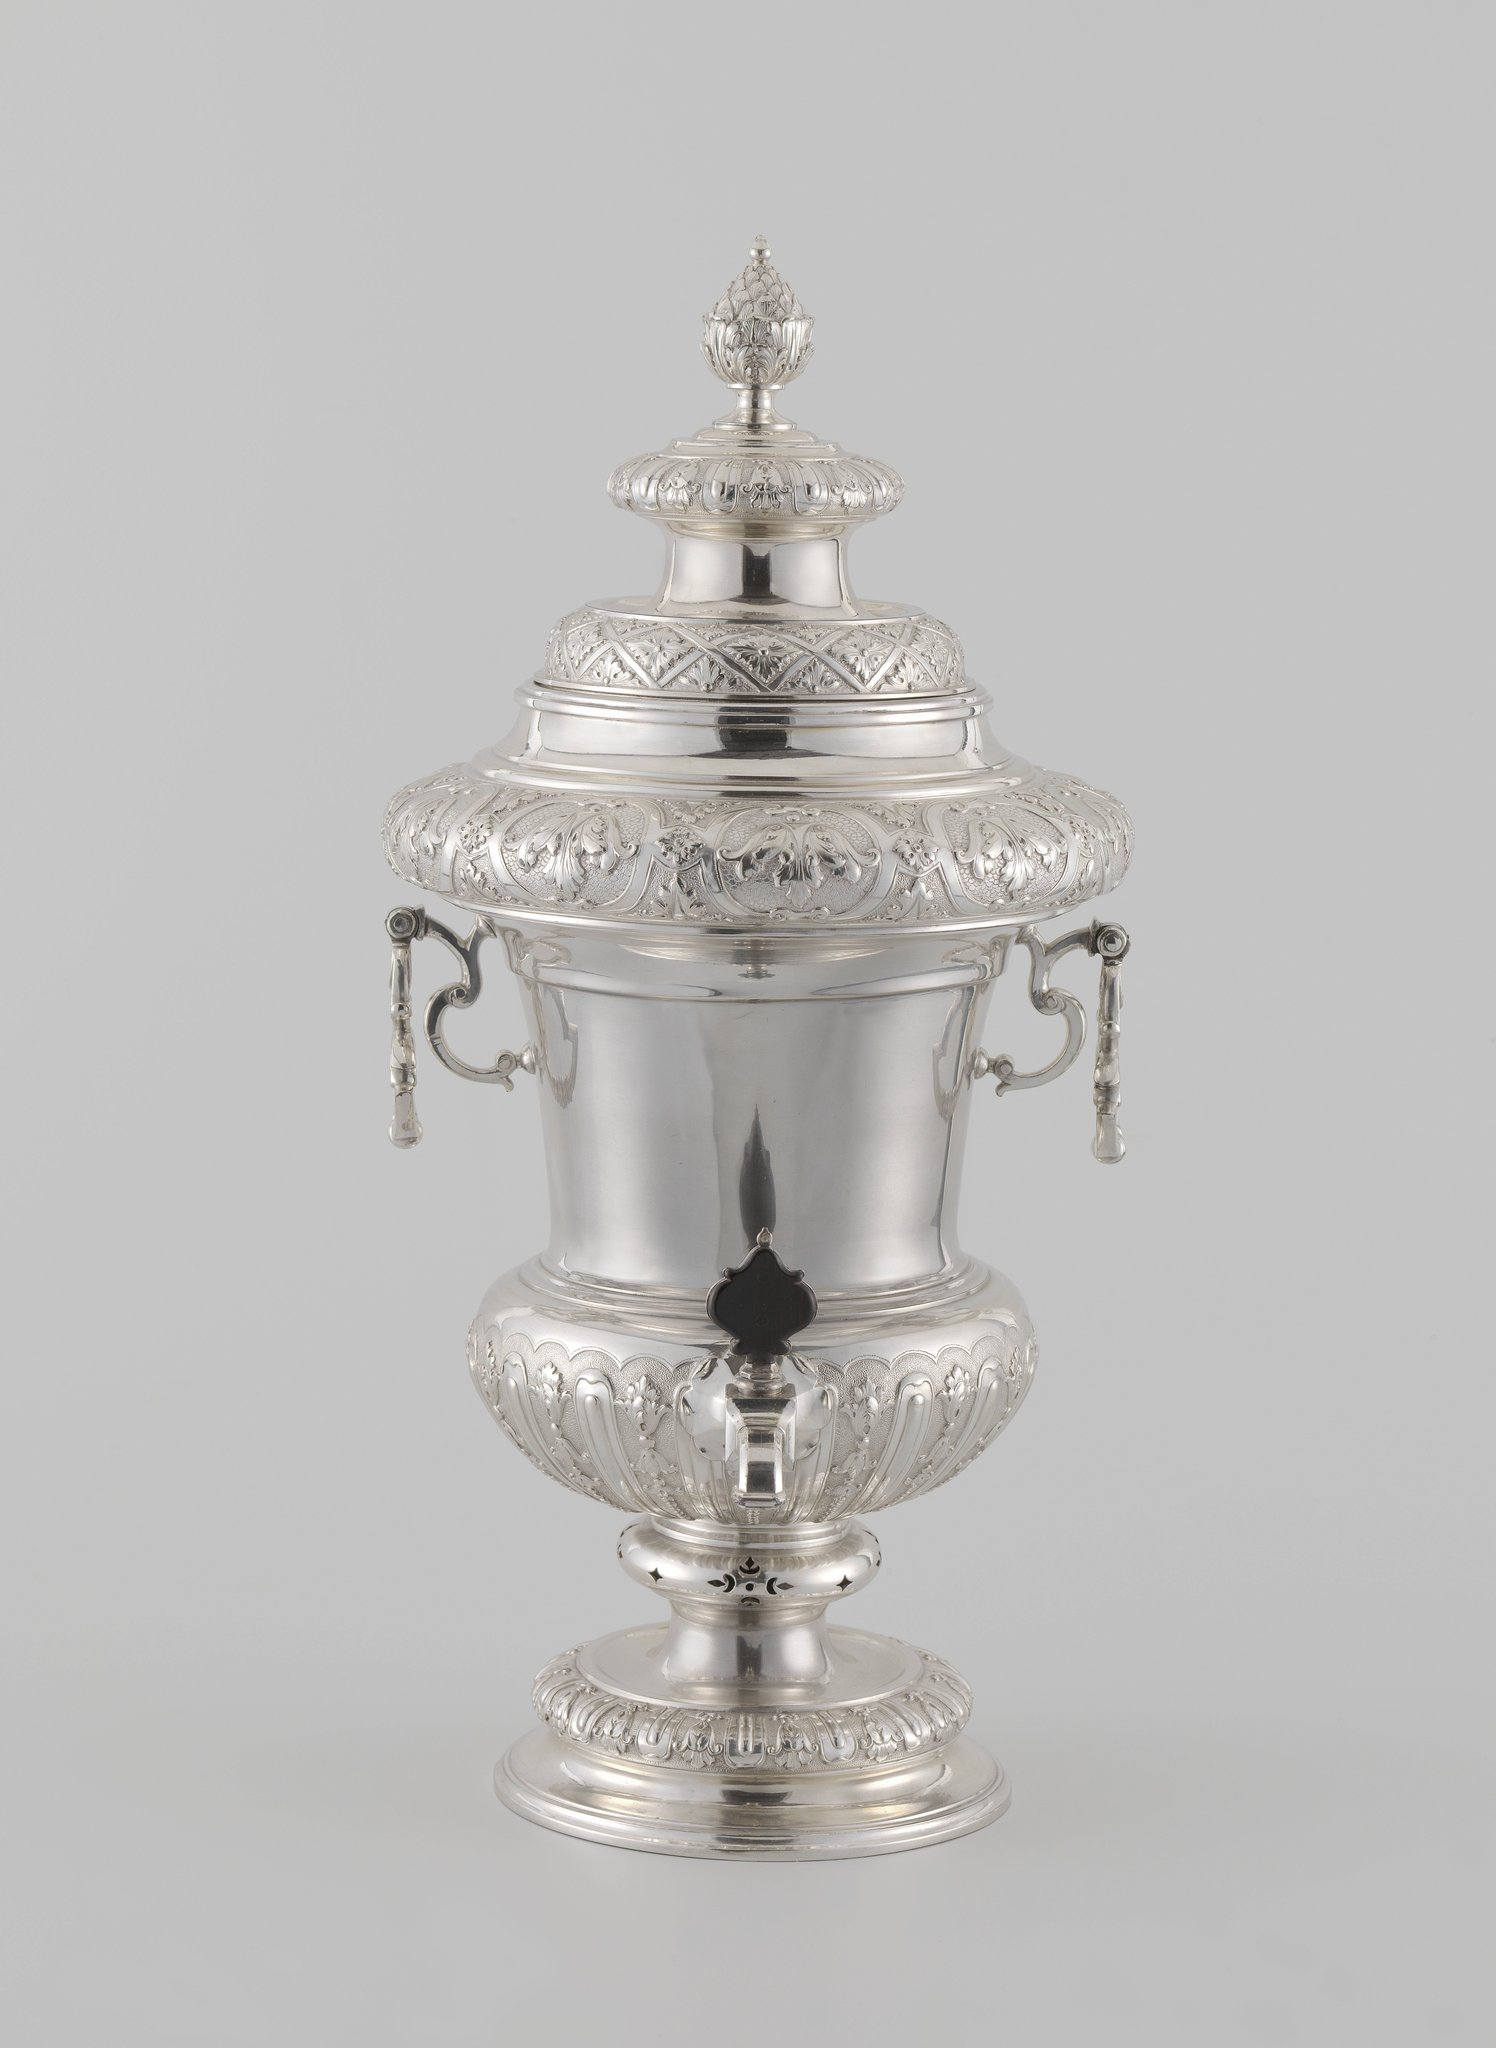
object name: coffee urn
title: Kraantjeskan in de vorm van een tuinvaas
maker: andele andeles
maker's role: medailleur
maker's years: 1687-1754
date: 1729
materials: silver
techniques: casting, embroidery, punching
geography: leeuwarden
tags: fruits: pine-cone, garden vase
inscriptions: maker's mark, date letter: ‘O’, town mark, alloy mark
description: Coffee urn. Silver. Leeuwarden, 1729, by Andele Andeles.